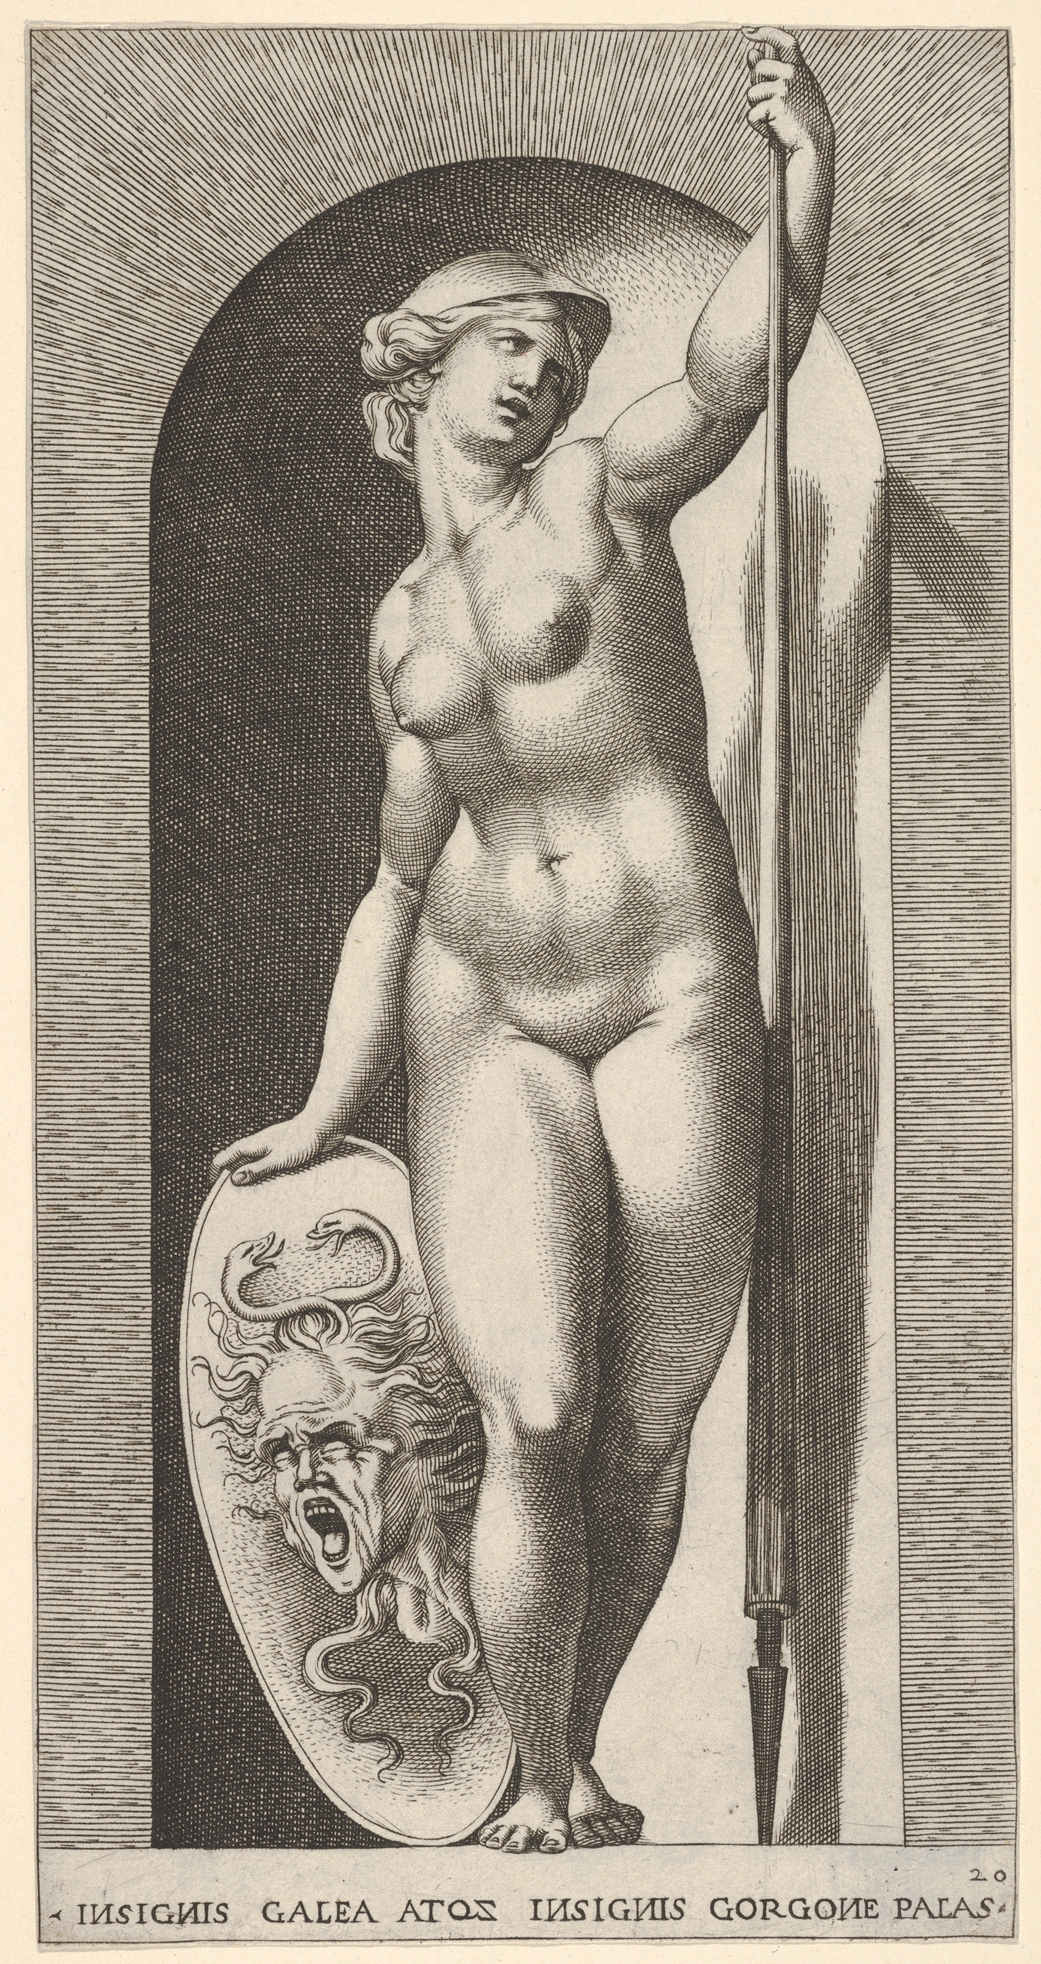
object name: print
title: Plate 20: Pallas Athena holding a shield with Medusa's head in her right hand and a lance in her left hand, from "Mythological Gods and Goddesses"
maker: giovanni jacopo caraglio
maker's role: artist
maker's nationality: italian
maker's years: 1500-1565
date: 1526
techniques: engraving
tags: shields,athena,medusa